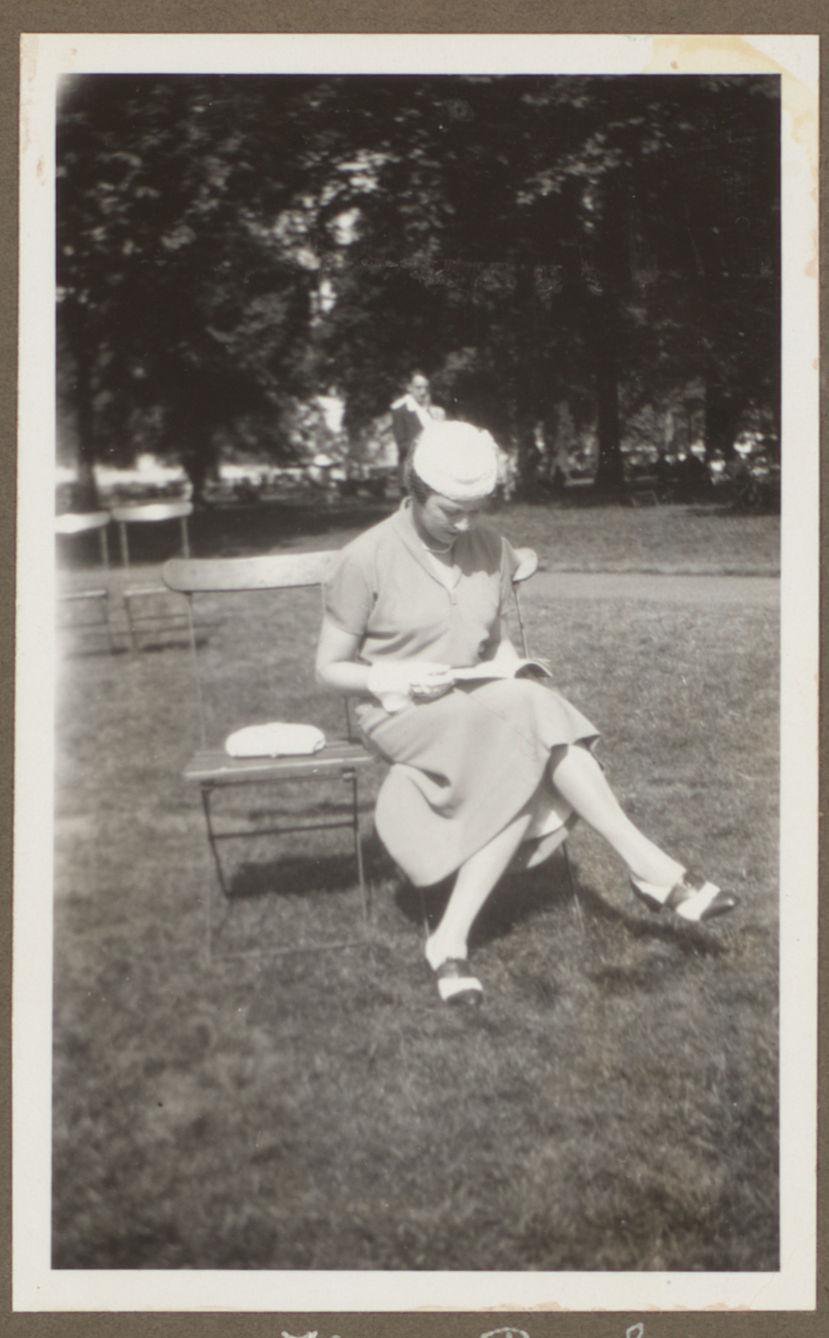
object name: photograph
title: Wilhelmina van Zijll de Jong lezend in Hyde Park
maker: Anonymous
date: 1906-1933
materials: paper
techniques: gelatin silver print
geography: london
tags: the hague, wilhelmina van zijll de jong, reading, historical persons - bb - woman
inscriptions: inscription: ‘Hyde Park’